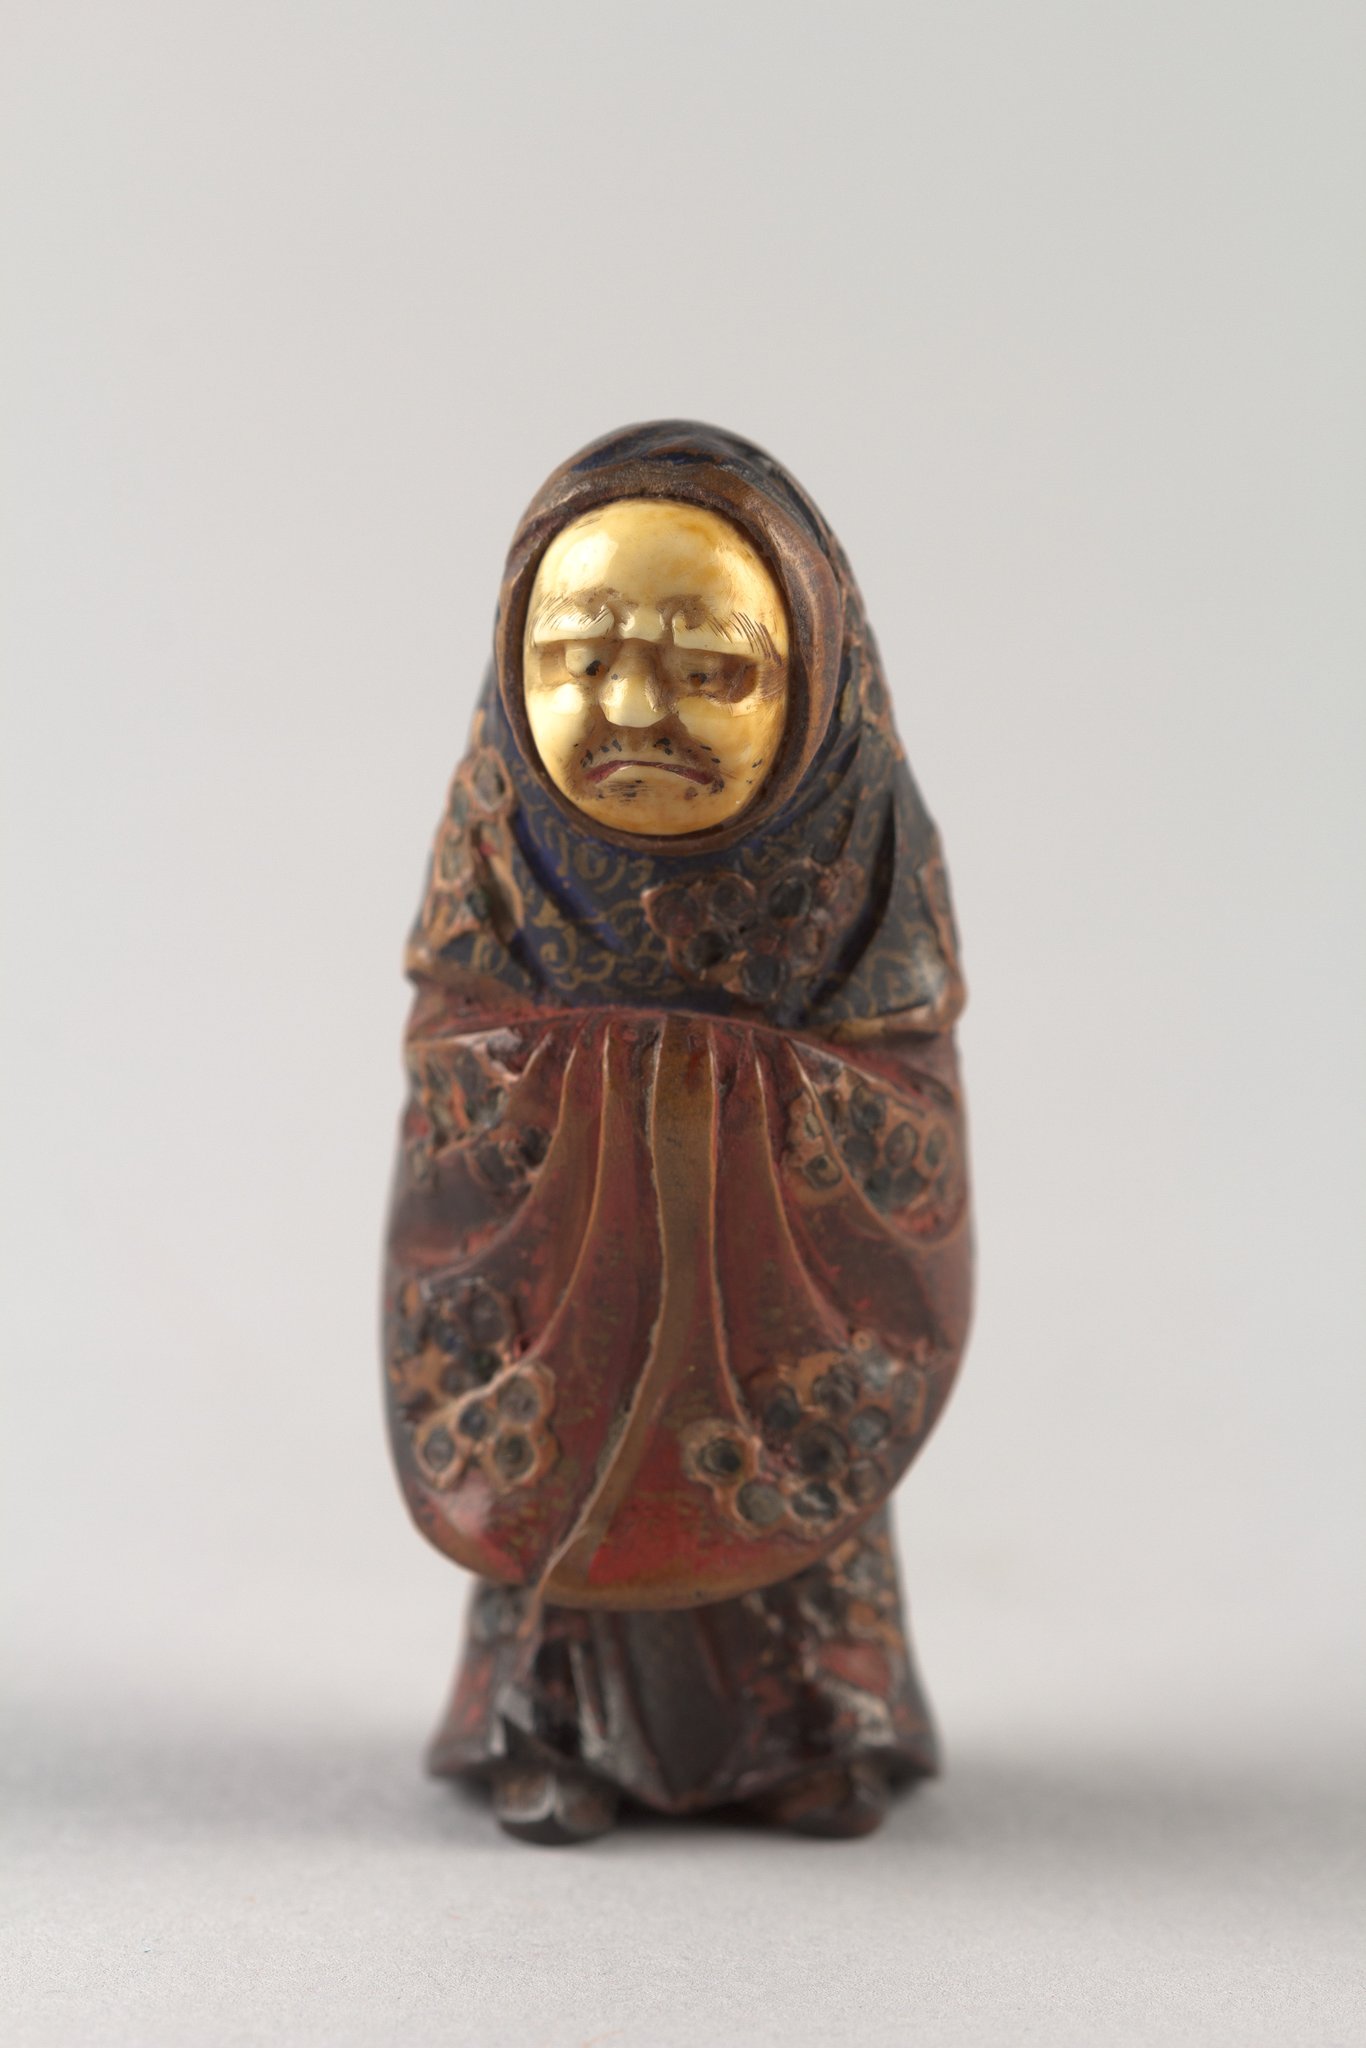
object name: netsuke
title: Netsuke of an Old Woman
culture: japanese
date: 1801-1900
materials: ivory, wood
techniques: lacquer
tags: women